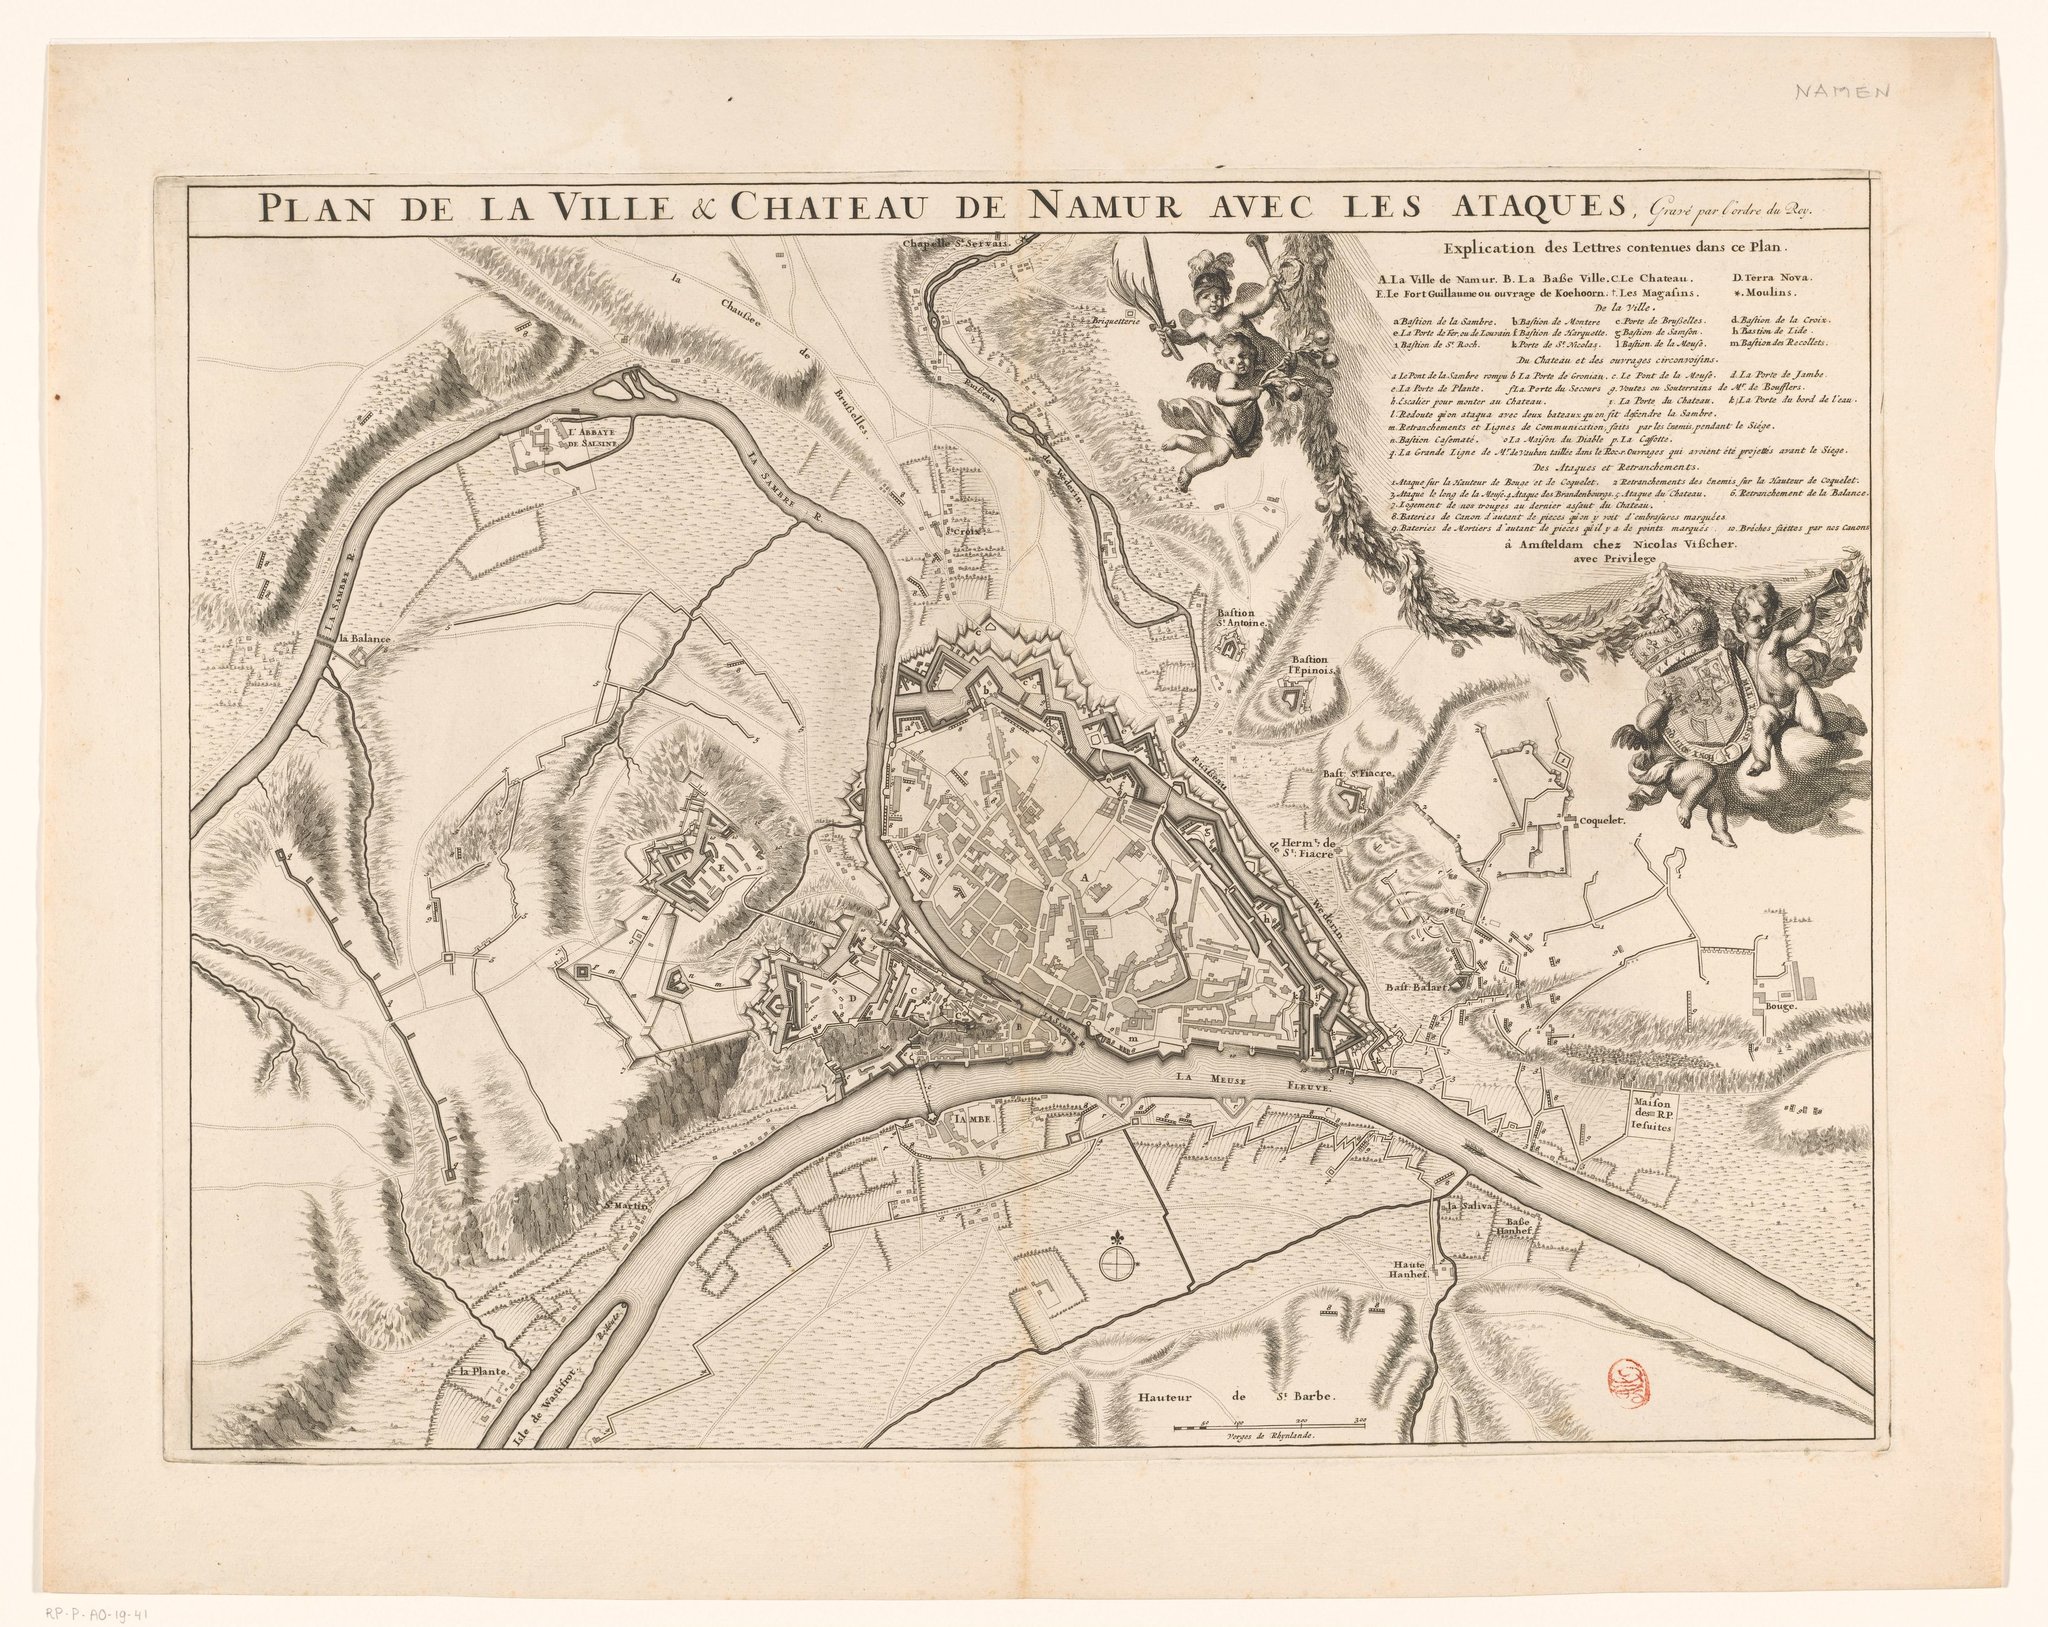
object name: area plan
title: Plattegrond van de stad Namen met het kasteel, belegerd door het Franse leger, 1692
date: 1692-1720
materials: paper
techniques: engraving, etching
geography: france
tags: siege, position war, maps of cities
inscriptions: collector's mark: Lugt 195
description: Plattegrond van de stad Namen met het kasteel, belegerd door het Franse leger, 25 mei - 30 juni 1692. Rechtsboven de legenda A-E, a-r en 1-10 in het Frans, met putti en het wapen van de koning van Frankrijk. Onder, rechts van het midden, een schaalstok: 300 Verges de Rhynlande.